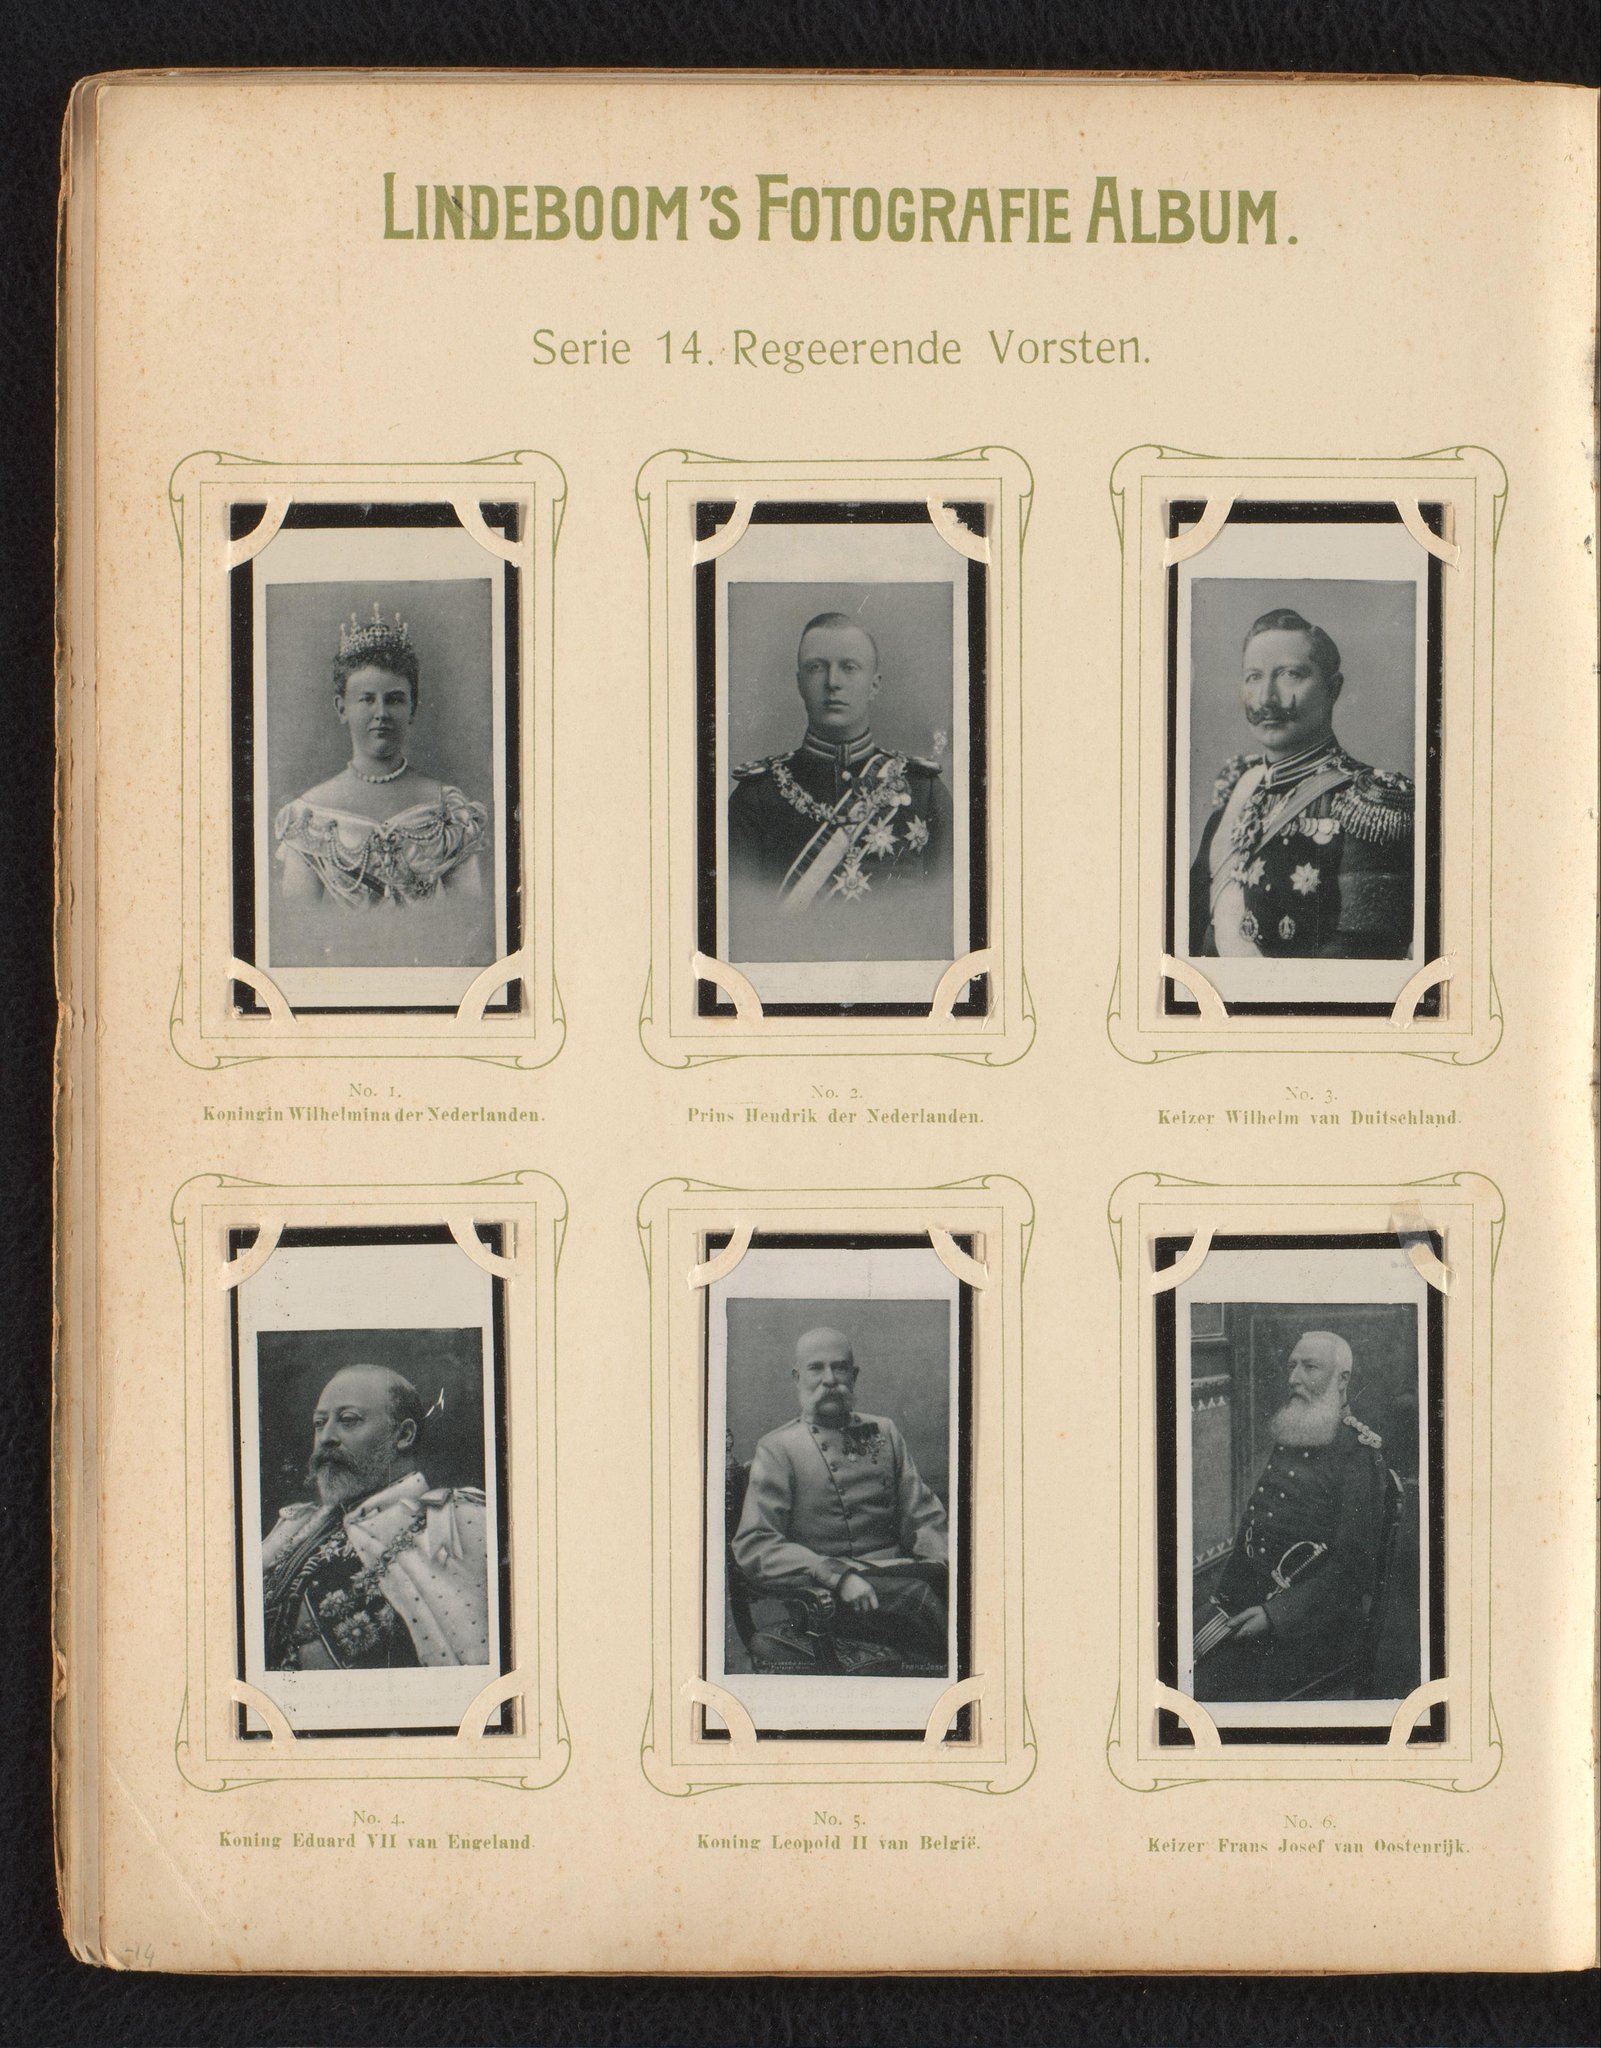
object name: album leaf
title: Zes reproducties van fotografische en geschilderde portretten van Europese vorsten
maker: Anonymous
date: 1905-1906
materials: cardboard, paper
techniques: photograph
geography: amsterdam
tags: brussels, laeken, leopold ii (koning der belgen), the hague, print maker, wilhelmina of the netherlands, vienna, hendrik (prins der nederlanden (1876-1934)), wilhelm ii (keizer van duitsland), historical persons, queen, emperor, king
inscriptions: inscription: ‘Serie 14.’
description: Dergelijke prenten stonden bekend als 'zwartjes'. Men verkreeg ze bij aanschaf van bepaalde merken thee, cacao, sigaretten, beschuit, etc. om te verzamelen. Er waren speciaal voor de 'zwartjes' vervaardigde verzamelalbums in omloop.